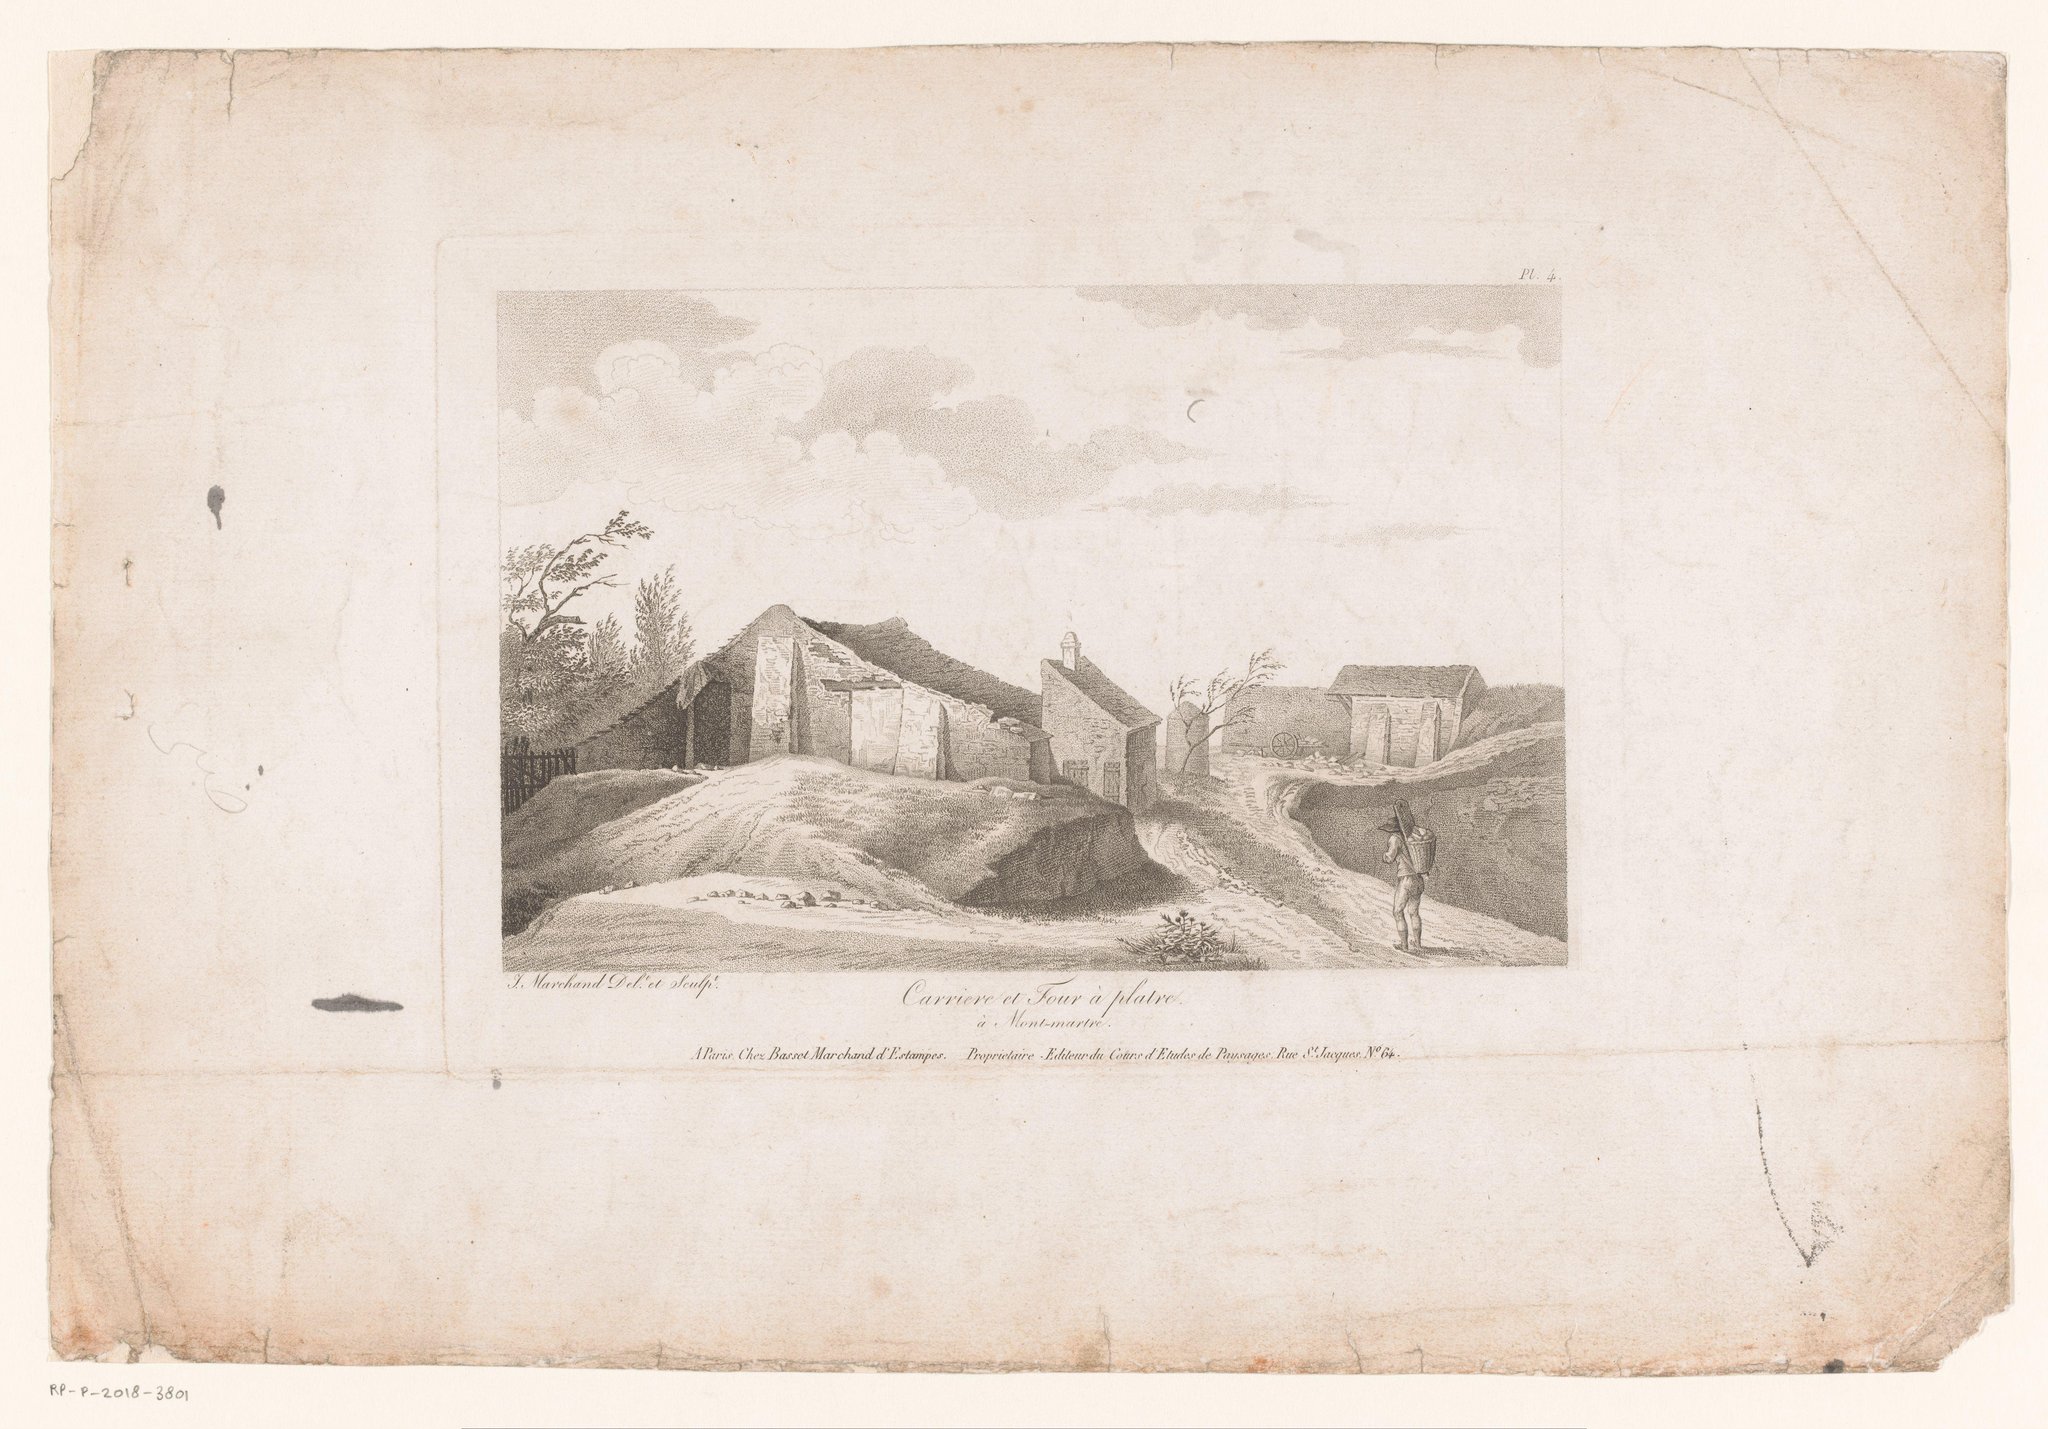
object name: print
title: Gezicht op een steengroeve met kalkoven in de buurt van Montmartre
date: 1779-1845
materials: paper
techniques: printmaking, etching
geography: paris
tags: industries ~ clay, sand, chalk, etc., fire, oven, furnace ~ interior of industrial structure, quarry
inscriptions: collector's mark: Lugt 2228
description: Maakt mogelijk deel uit van een serie prenten met landschappen en gezichten op binnenplaatsen, getiteld 'Premier Cahier'.